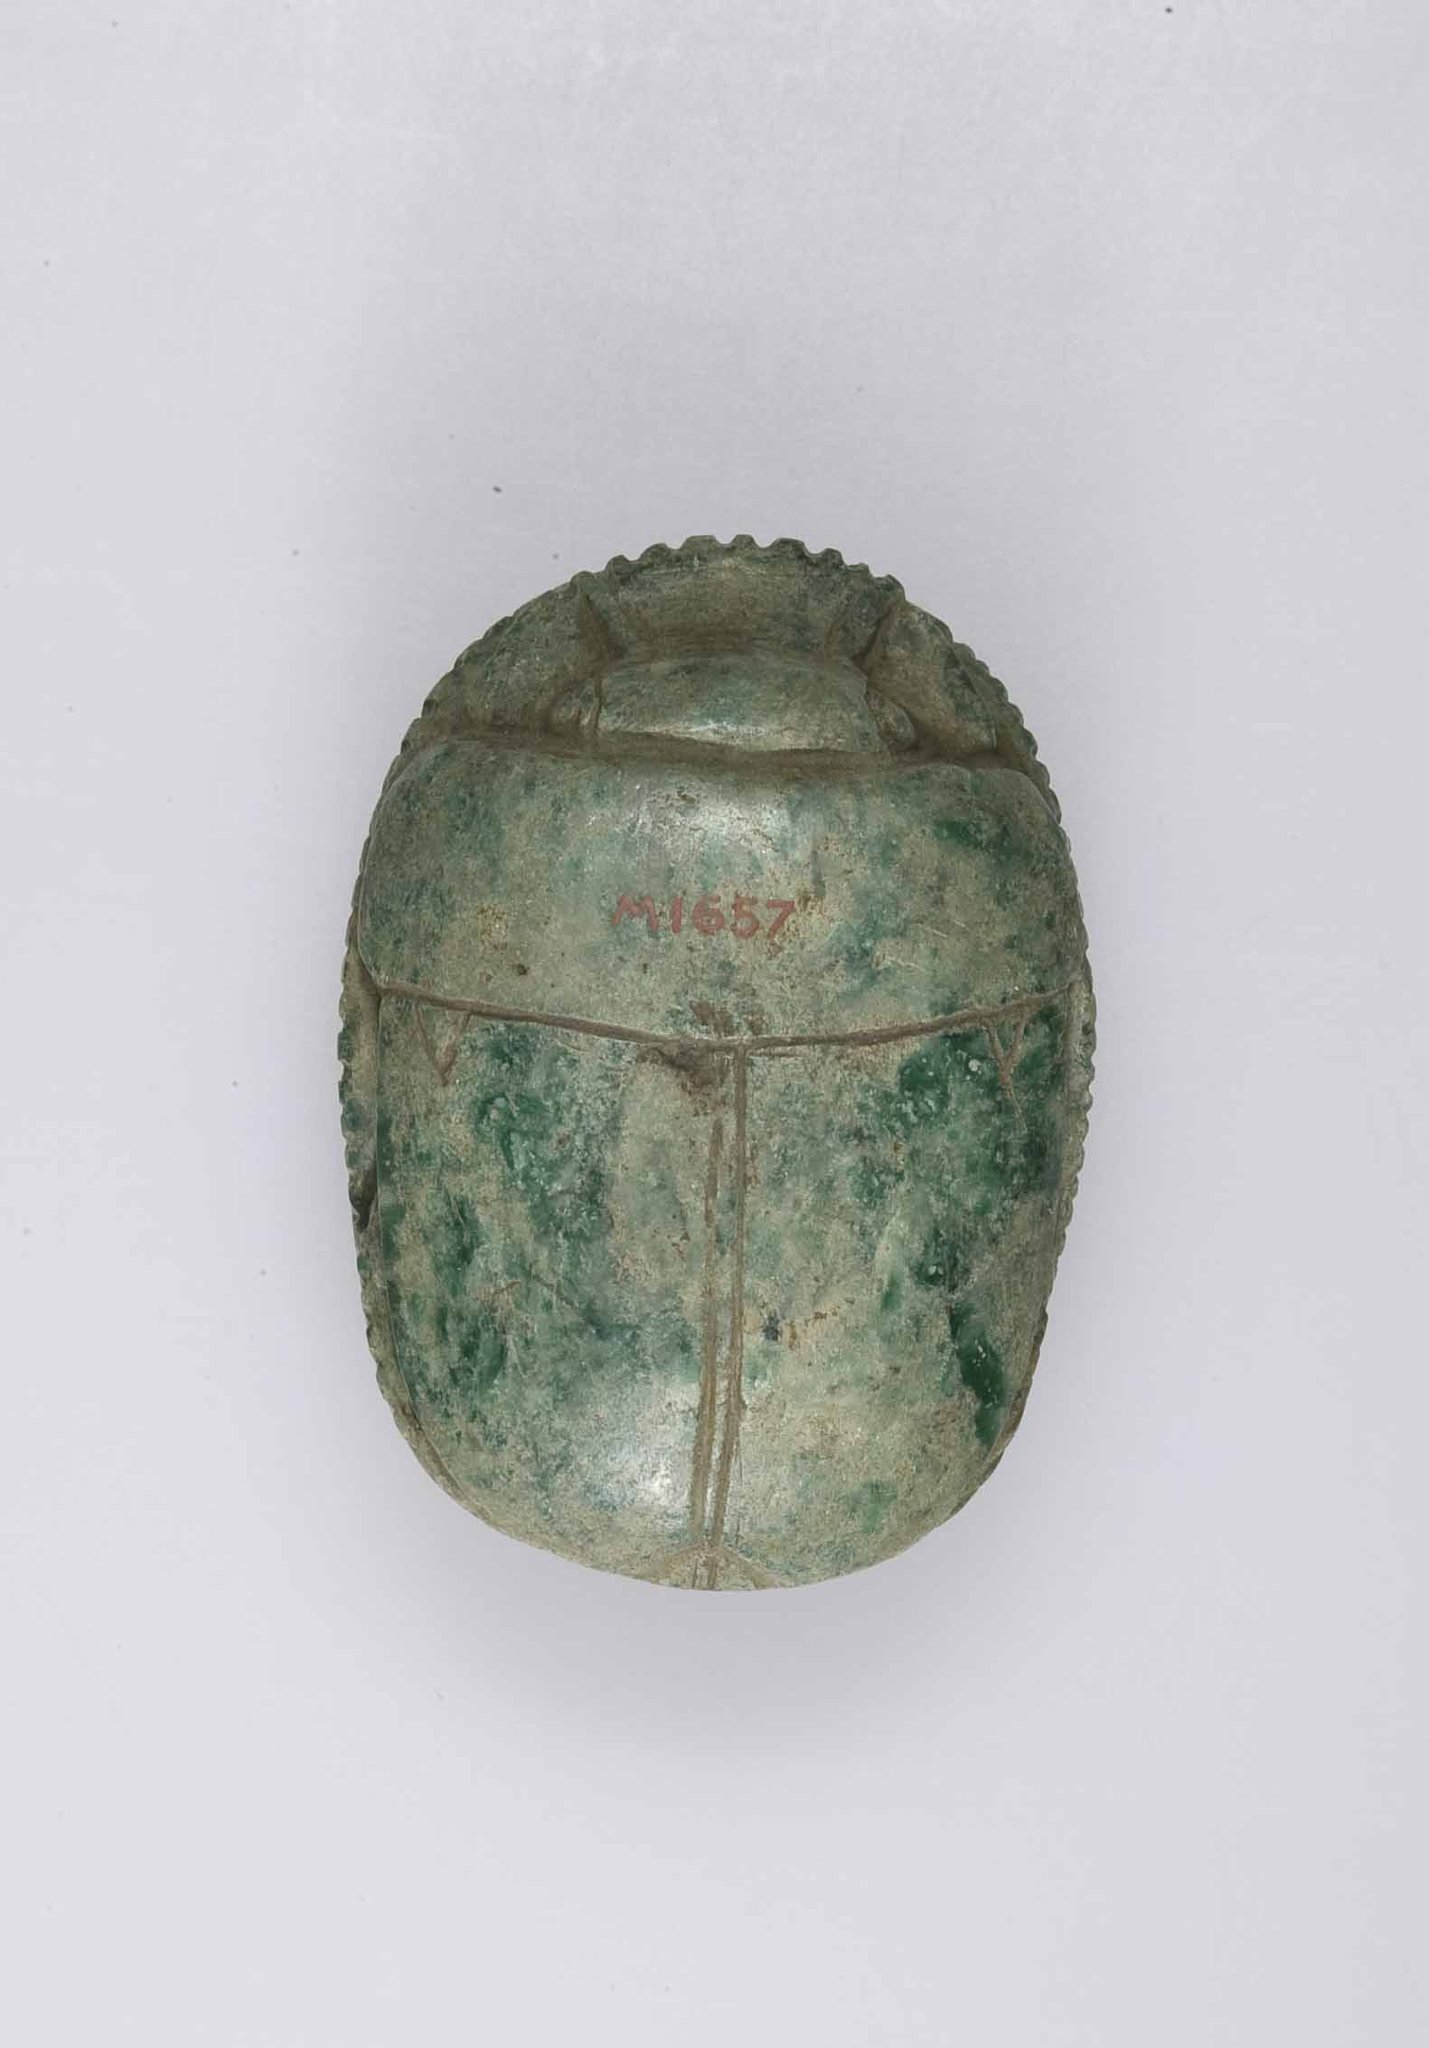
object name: heart scarab, uninscribed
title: Heart Scarab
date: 1295-1070 BCE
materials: stone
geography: egypt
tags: scarabs